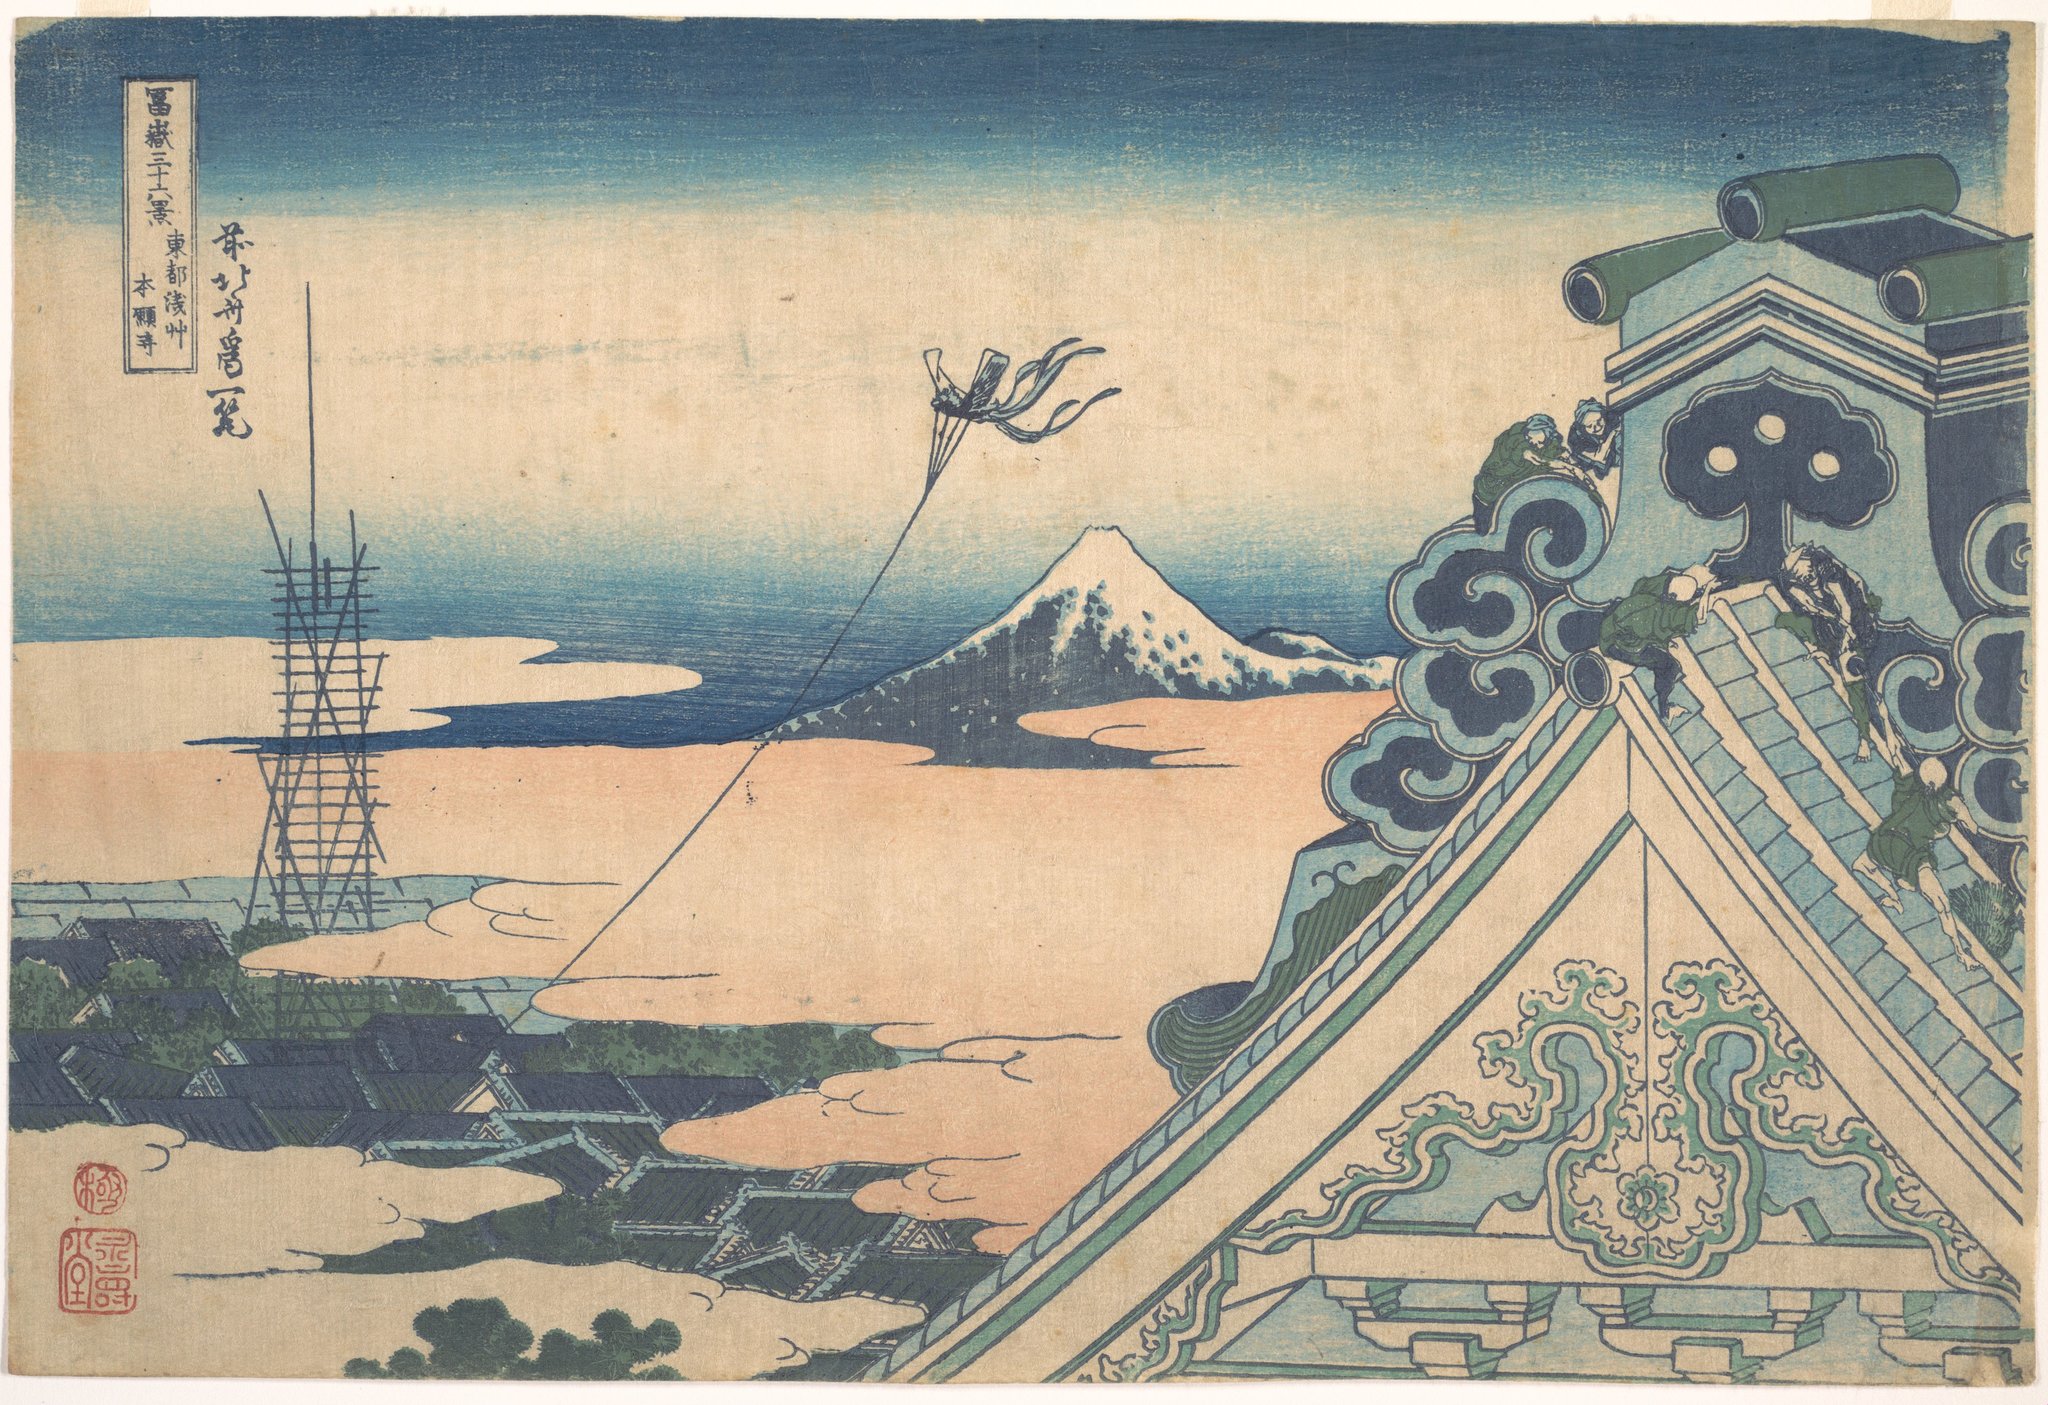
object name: woodblock print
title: Honganji at Asakusa in Edo (Tōto Asakusa Honganji), from the series Thirty-six Views of Mount Fuji (Fugaku sanjūrokkei)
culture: japanese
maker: katsushika hokusai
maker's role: artist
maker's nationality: japanese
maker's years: 1760-1849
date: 1830-1832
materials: ink, paper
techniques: woodblock print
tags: temples,mountains